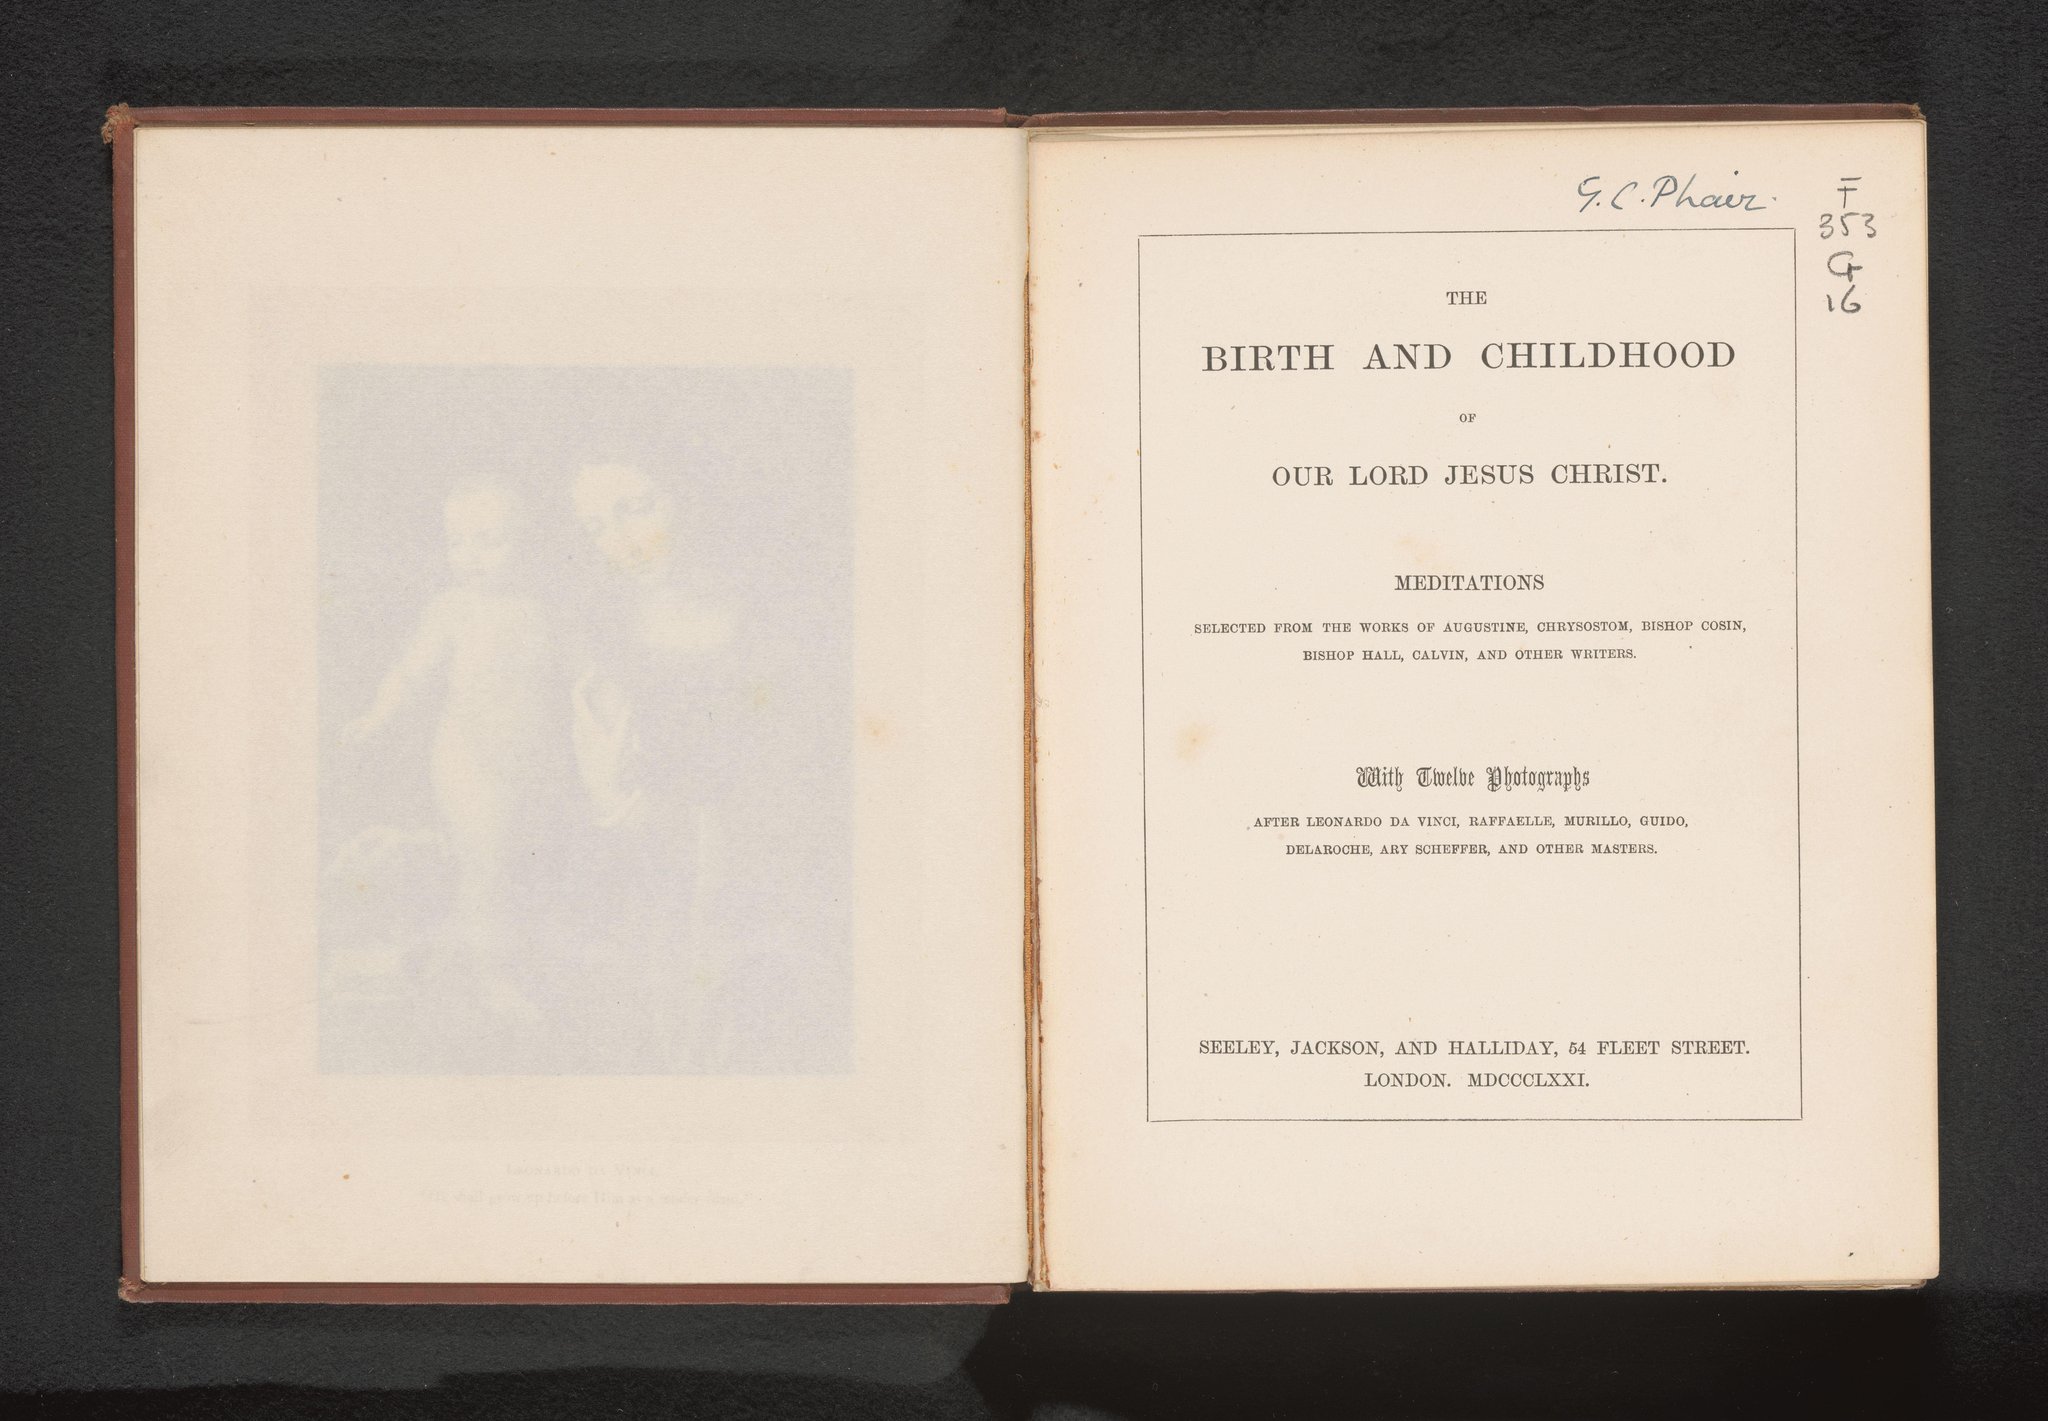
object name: book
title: The birth and childhood of our Lord Jesus Christ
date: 1871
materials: cardboard, linen, paper, photographic support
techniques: albumen print, printing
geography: london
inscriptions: name: ‘G.C. Phair’